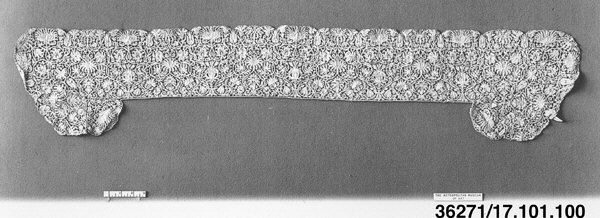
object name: piece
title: Finished piece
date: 1601-1633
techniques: lace